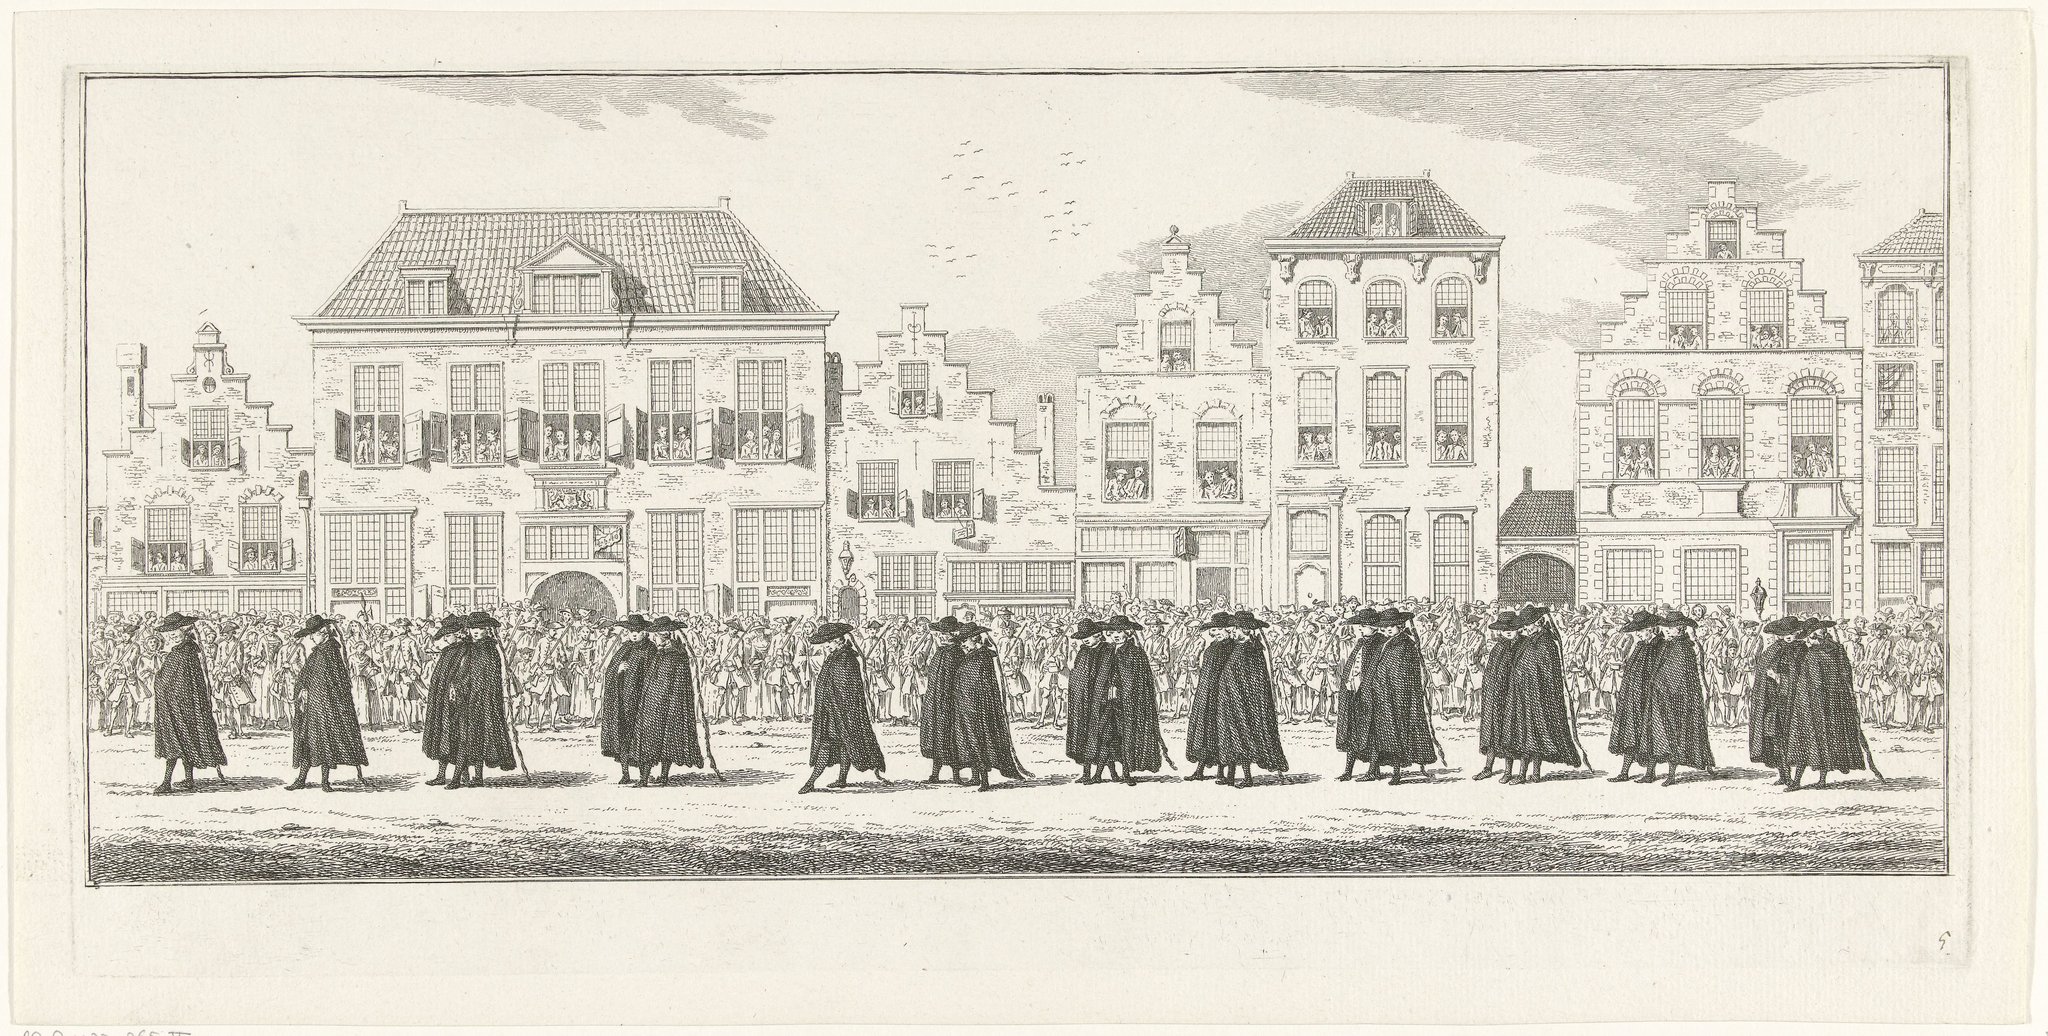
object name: print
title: Hofdienaren in de lijkstoet van Anna van Hannover te Delft, 1759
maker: simon fokke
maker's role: draughtsman, print maker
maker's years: 1712-1784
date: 1759-1761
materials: paper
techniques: etching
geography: amsterdam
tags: the hague, anna van hannover, cortege, funeral procession, delft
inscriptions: collector's mark: Lugt 2228, serial number: ‘5’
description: Leden van de stadhouderlijke hofhouding. Onderdeel van een serie van 16 platen in etsdruk van de lijkstatie van de op 23 februari 1759 te Delft begraven prinses Anna van Hannover.